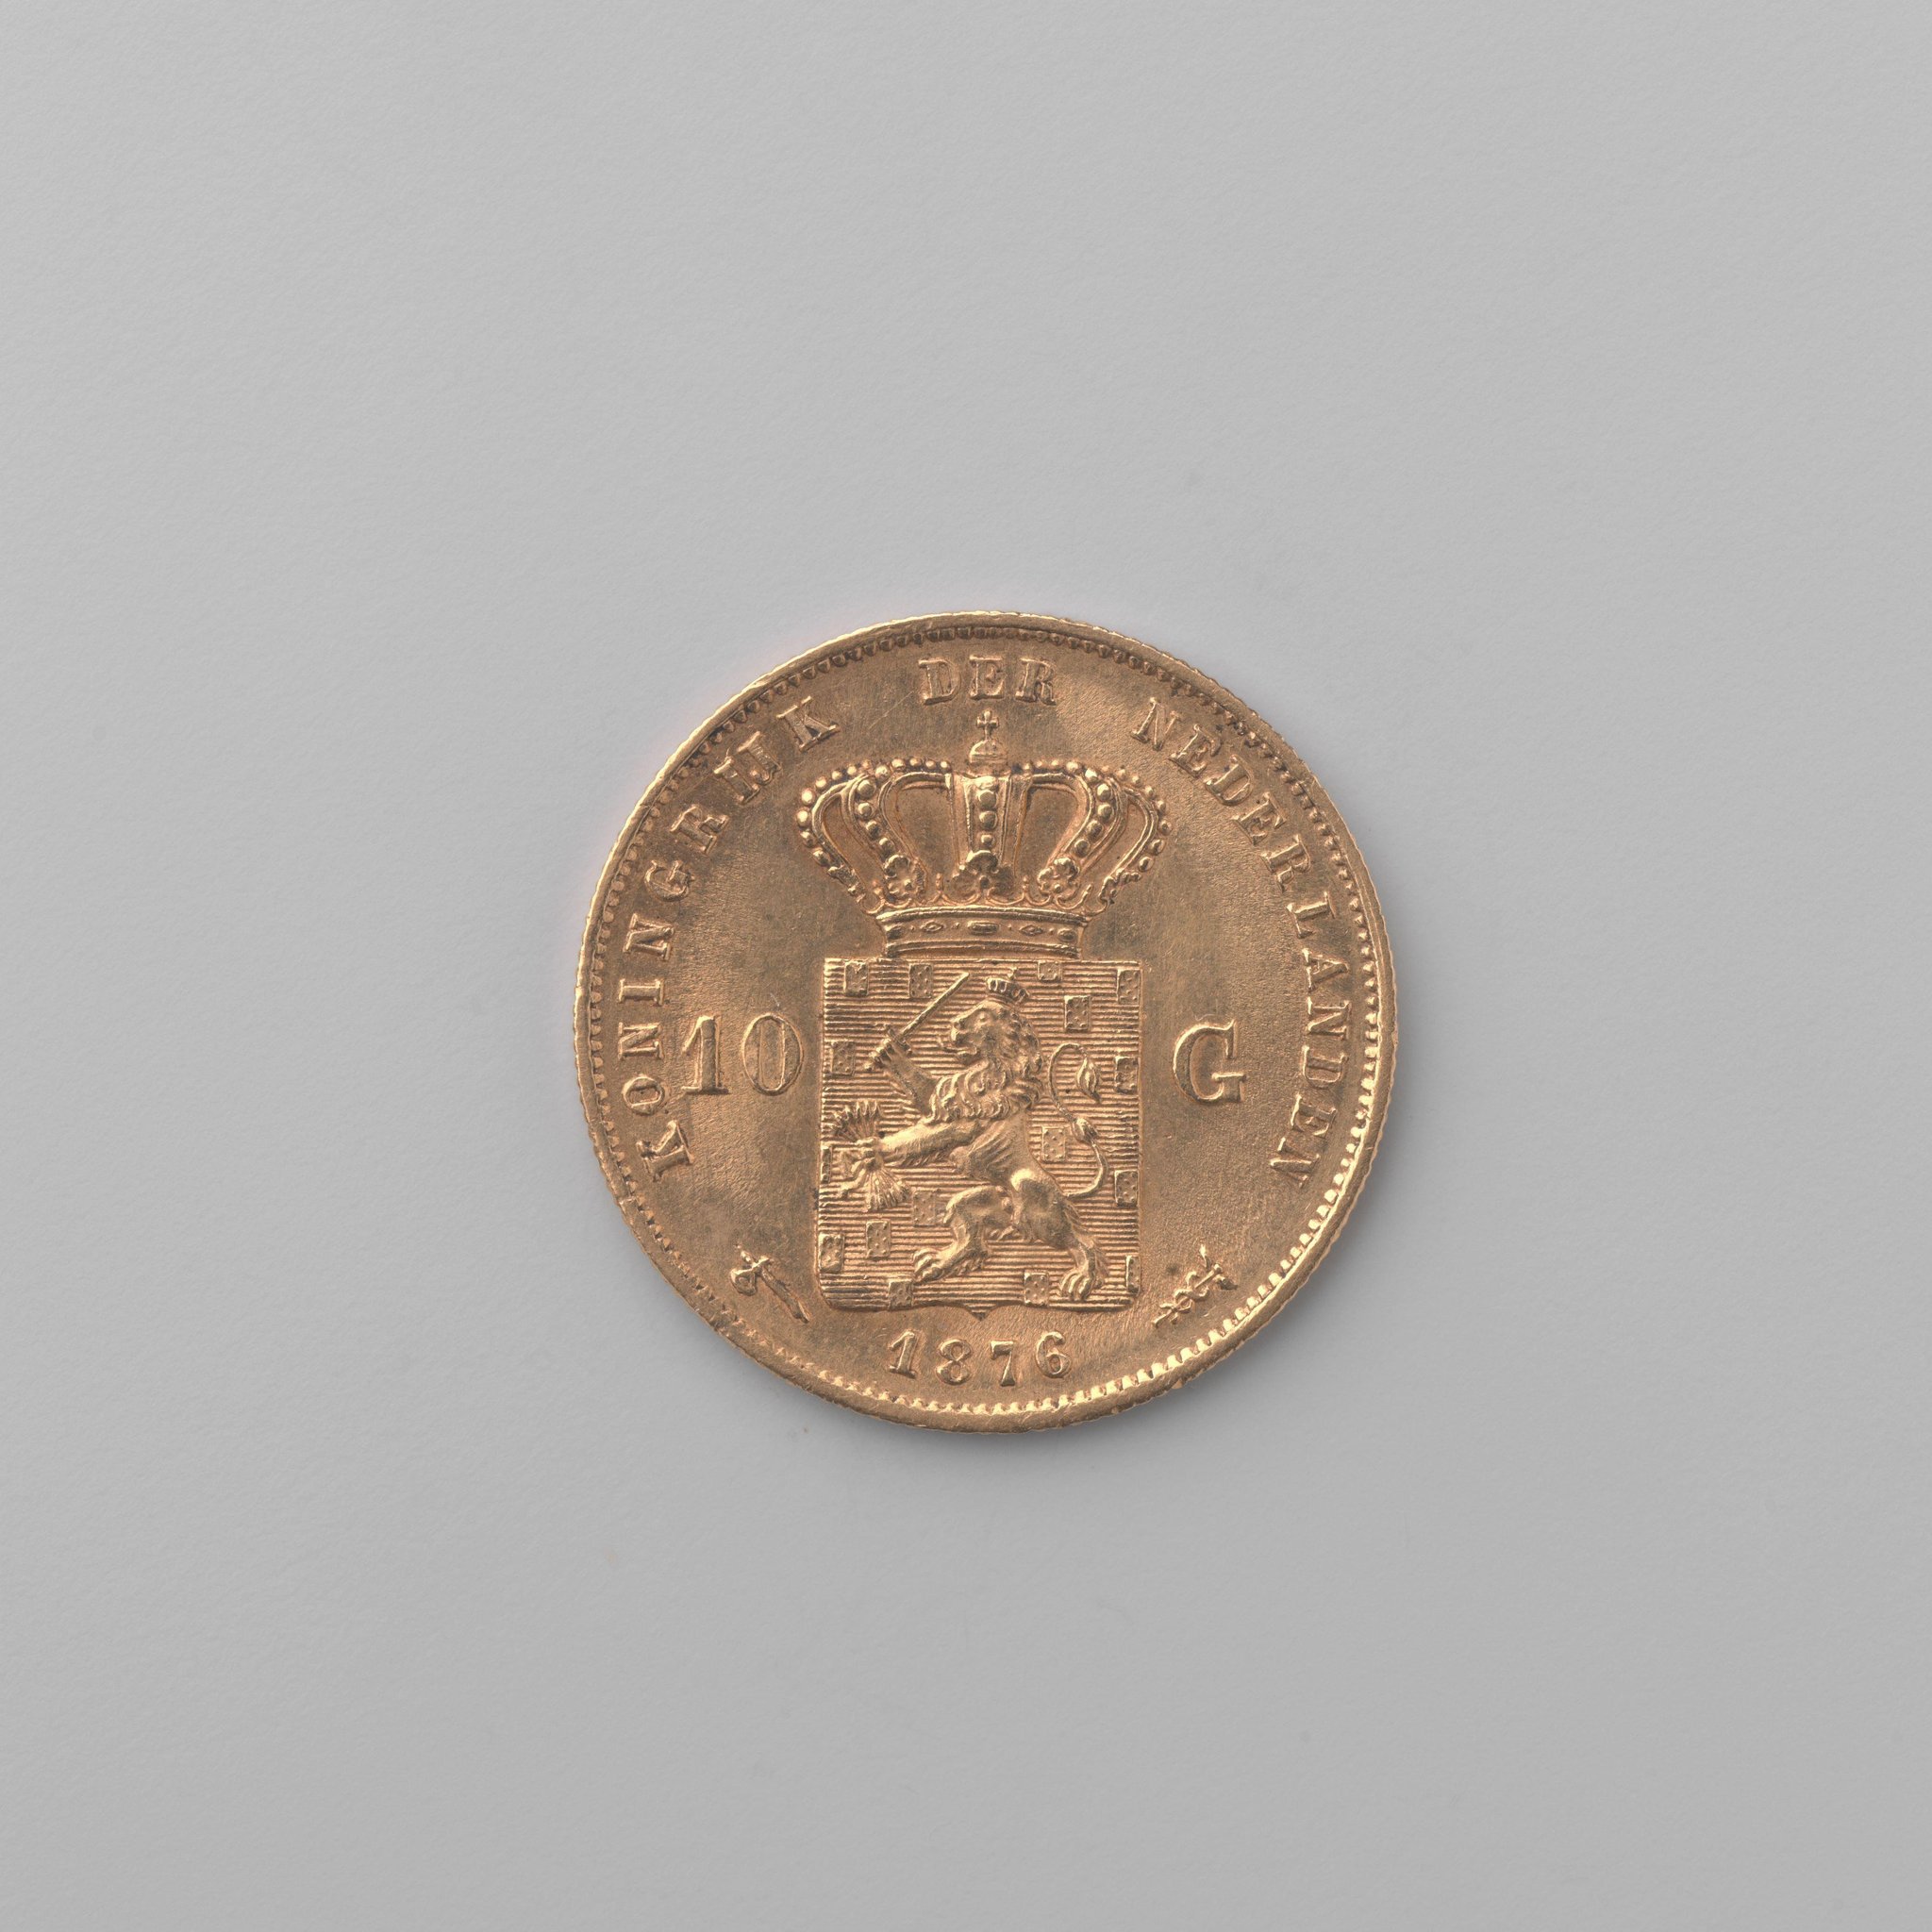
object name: tien gulden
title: Nederland, 10 gulden, 1876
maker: willem iii (koning der nederlanden)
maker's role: koning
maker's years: 1817-1890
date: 1876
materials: gold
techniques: striking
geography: utrecht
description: Gouden munt. Voorzijde:hoofd naar rechts. Keerzijde: tussen waarde-aanduiding 10 G gekroond rijkswapenschild. Jaartal onderaan in omschrift. Kartelrand.